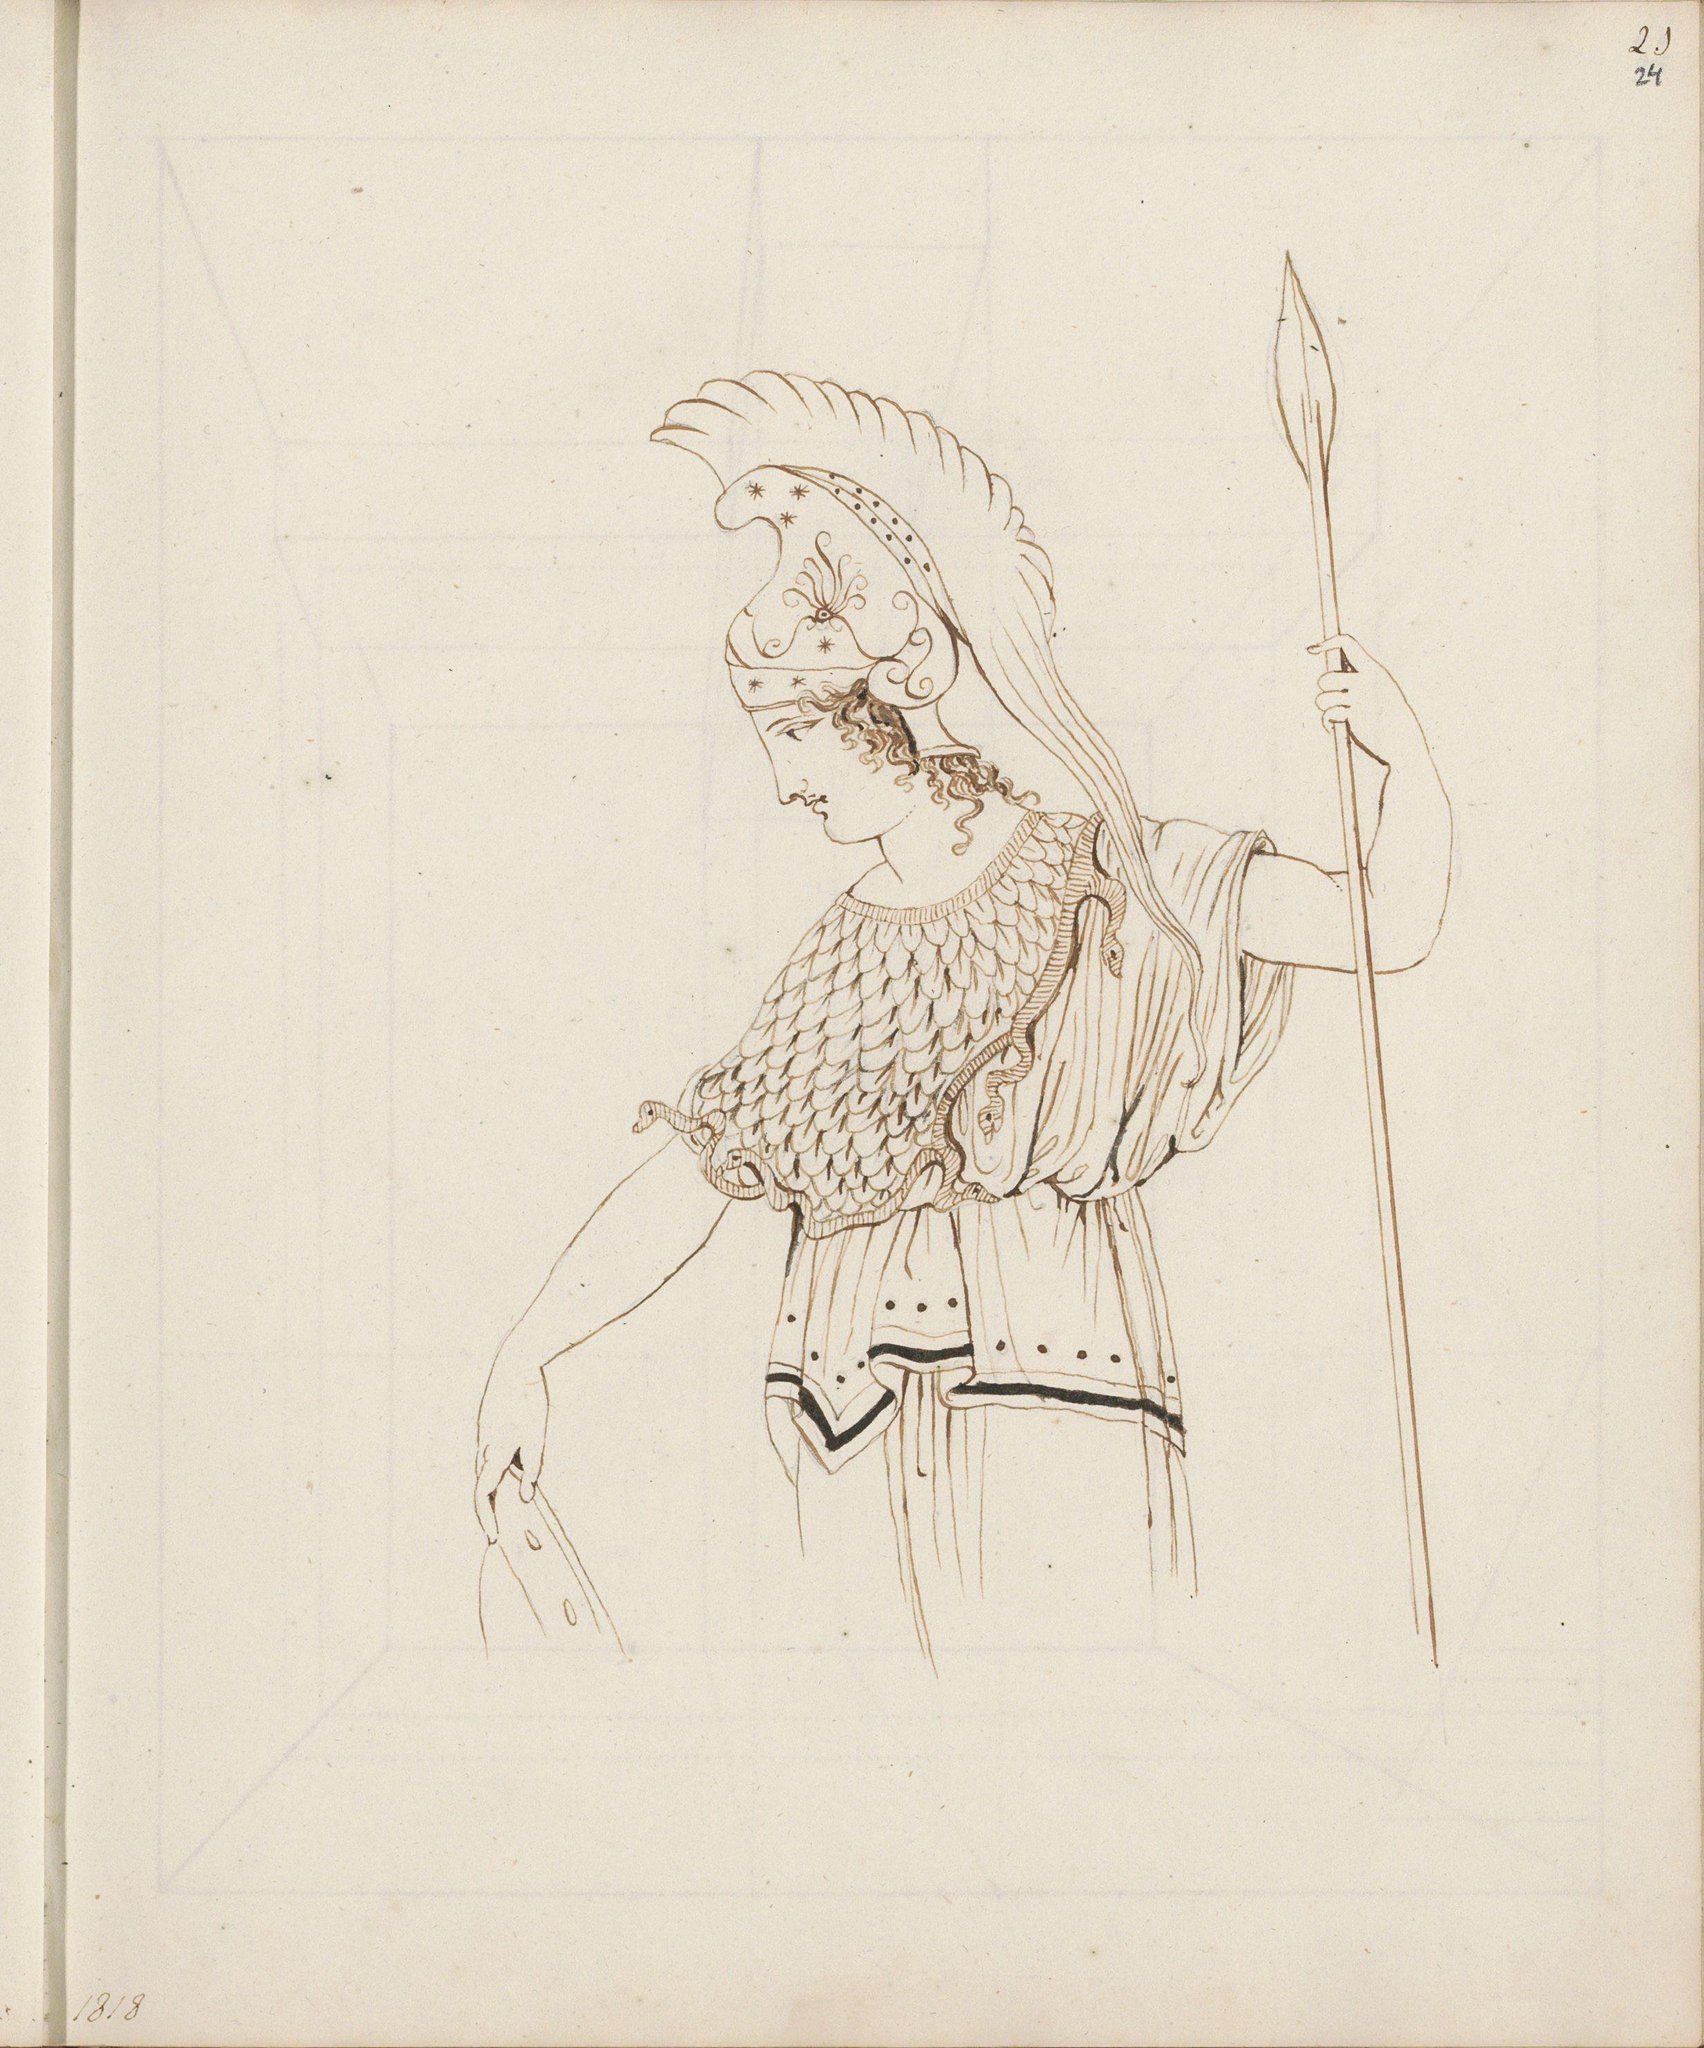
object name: sketchbook leaf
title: Pallas Athena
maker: jonkvrouw elisabeth kemper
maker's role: draughtsman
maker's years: 1799-1871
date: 1818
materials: ink, paper, pencil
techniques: pen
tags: (story of) minerva (pallas, athena)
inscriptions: date: ‘1818’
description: Pallas Athena draagt een helm en tuniek met een slang erover gedrapeerd. In haar handen een schild en speer. Vermoedelijk getekend naar klassiek voorbeeld. Blad 24 recto uit een schetsboek met 94 bladen.